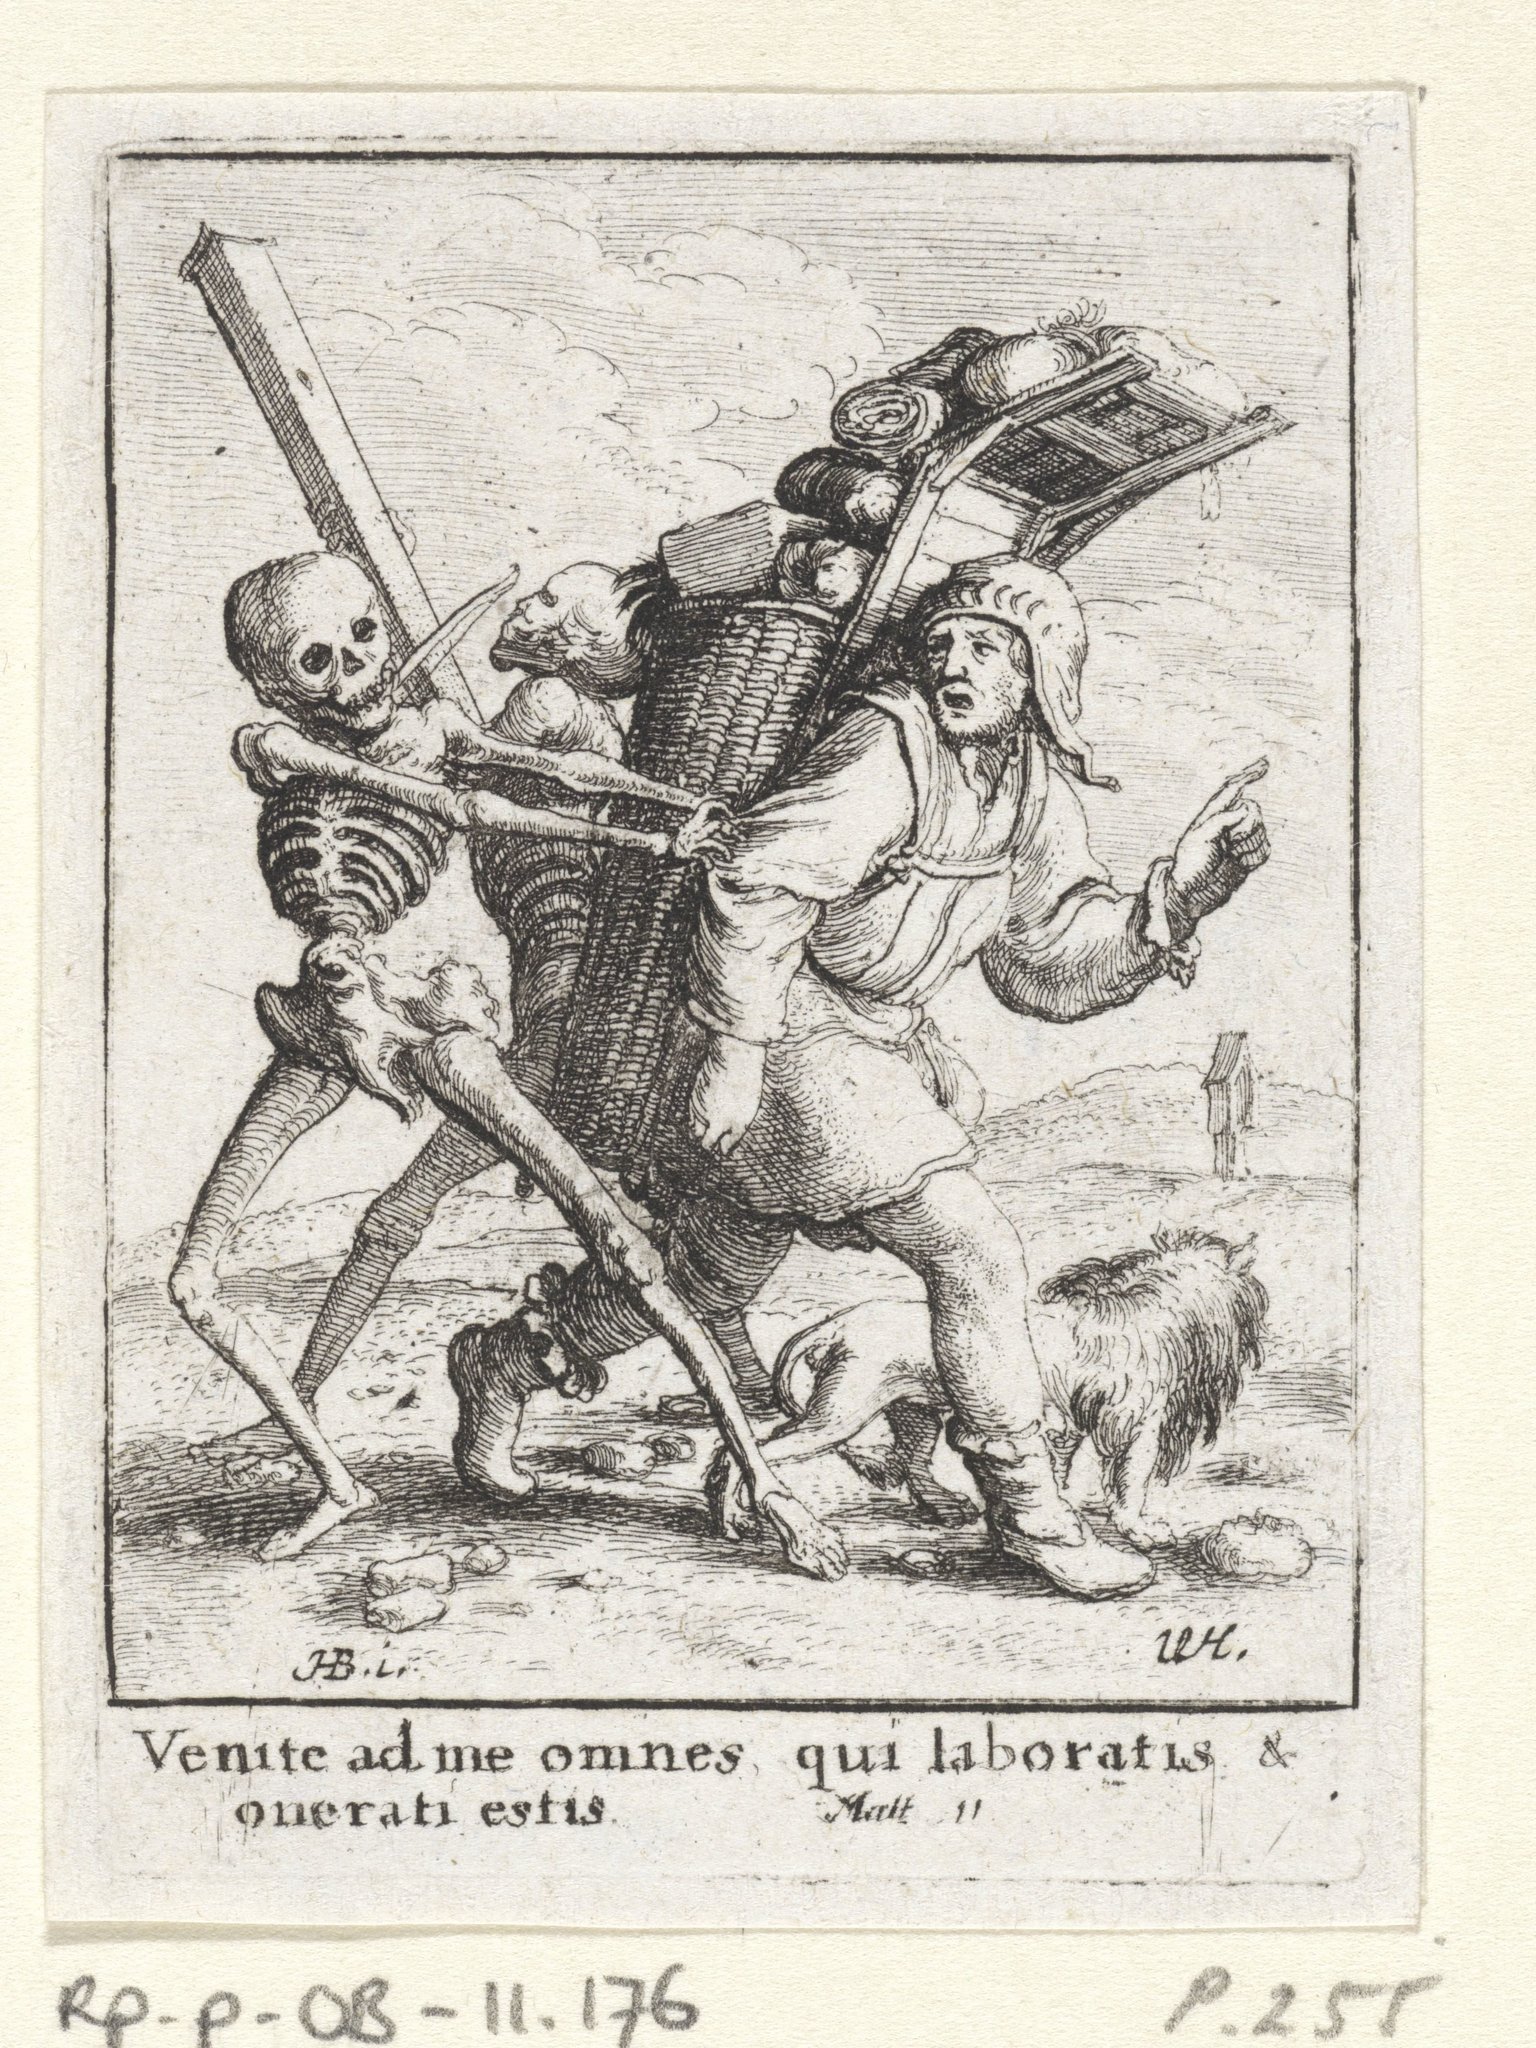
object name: book illustration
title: De marskramer en de Dood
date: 1680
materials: paper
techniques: etching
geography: antwerp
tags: dance of death; death together with one or more human beings, pedlar, hourglass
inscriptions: collector's mark: Lugt 240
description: Een marskramer wordt door twee geraamtes overvallen. Een leeuw loopt tussen zijn benen door.